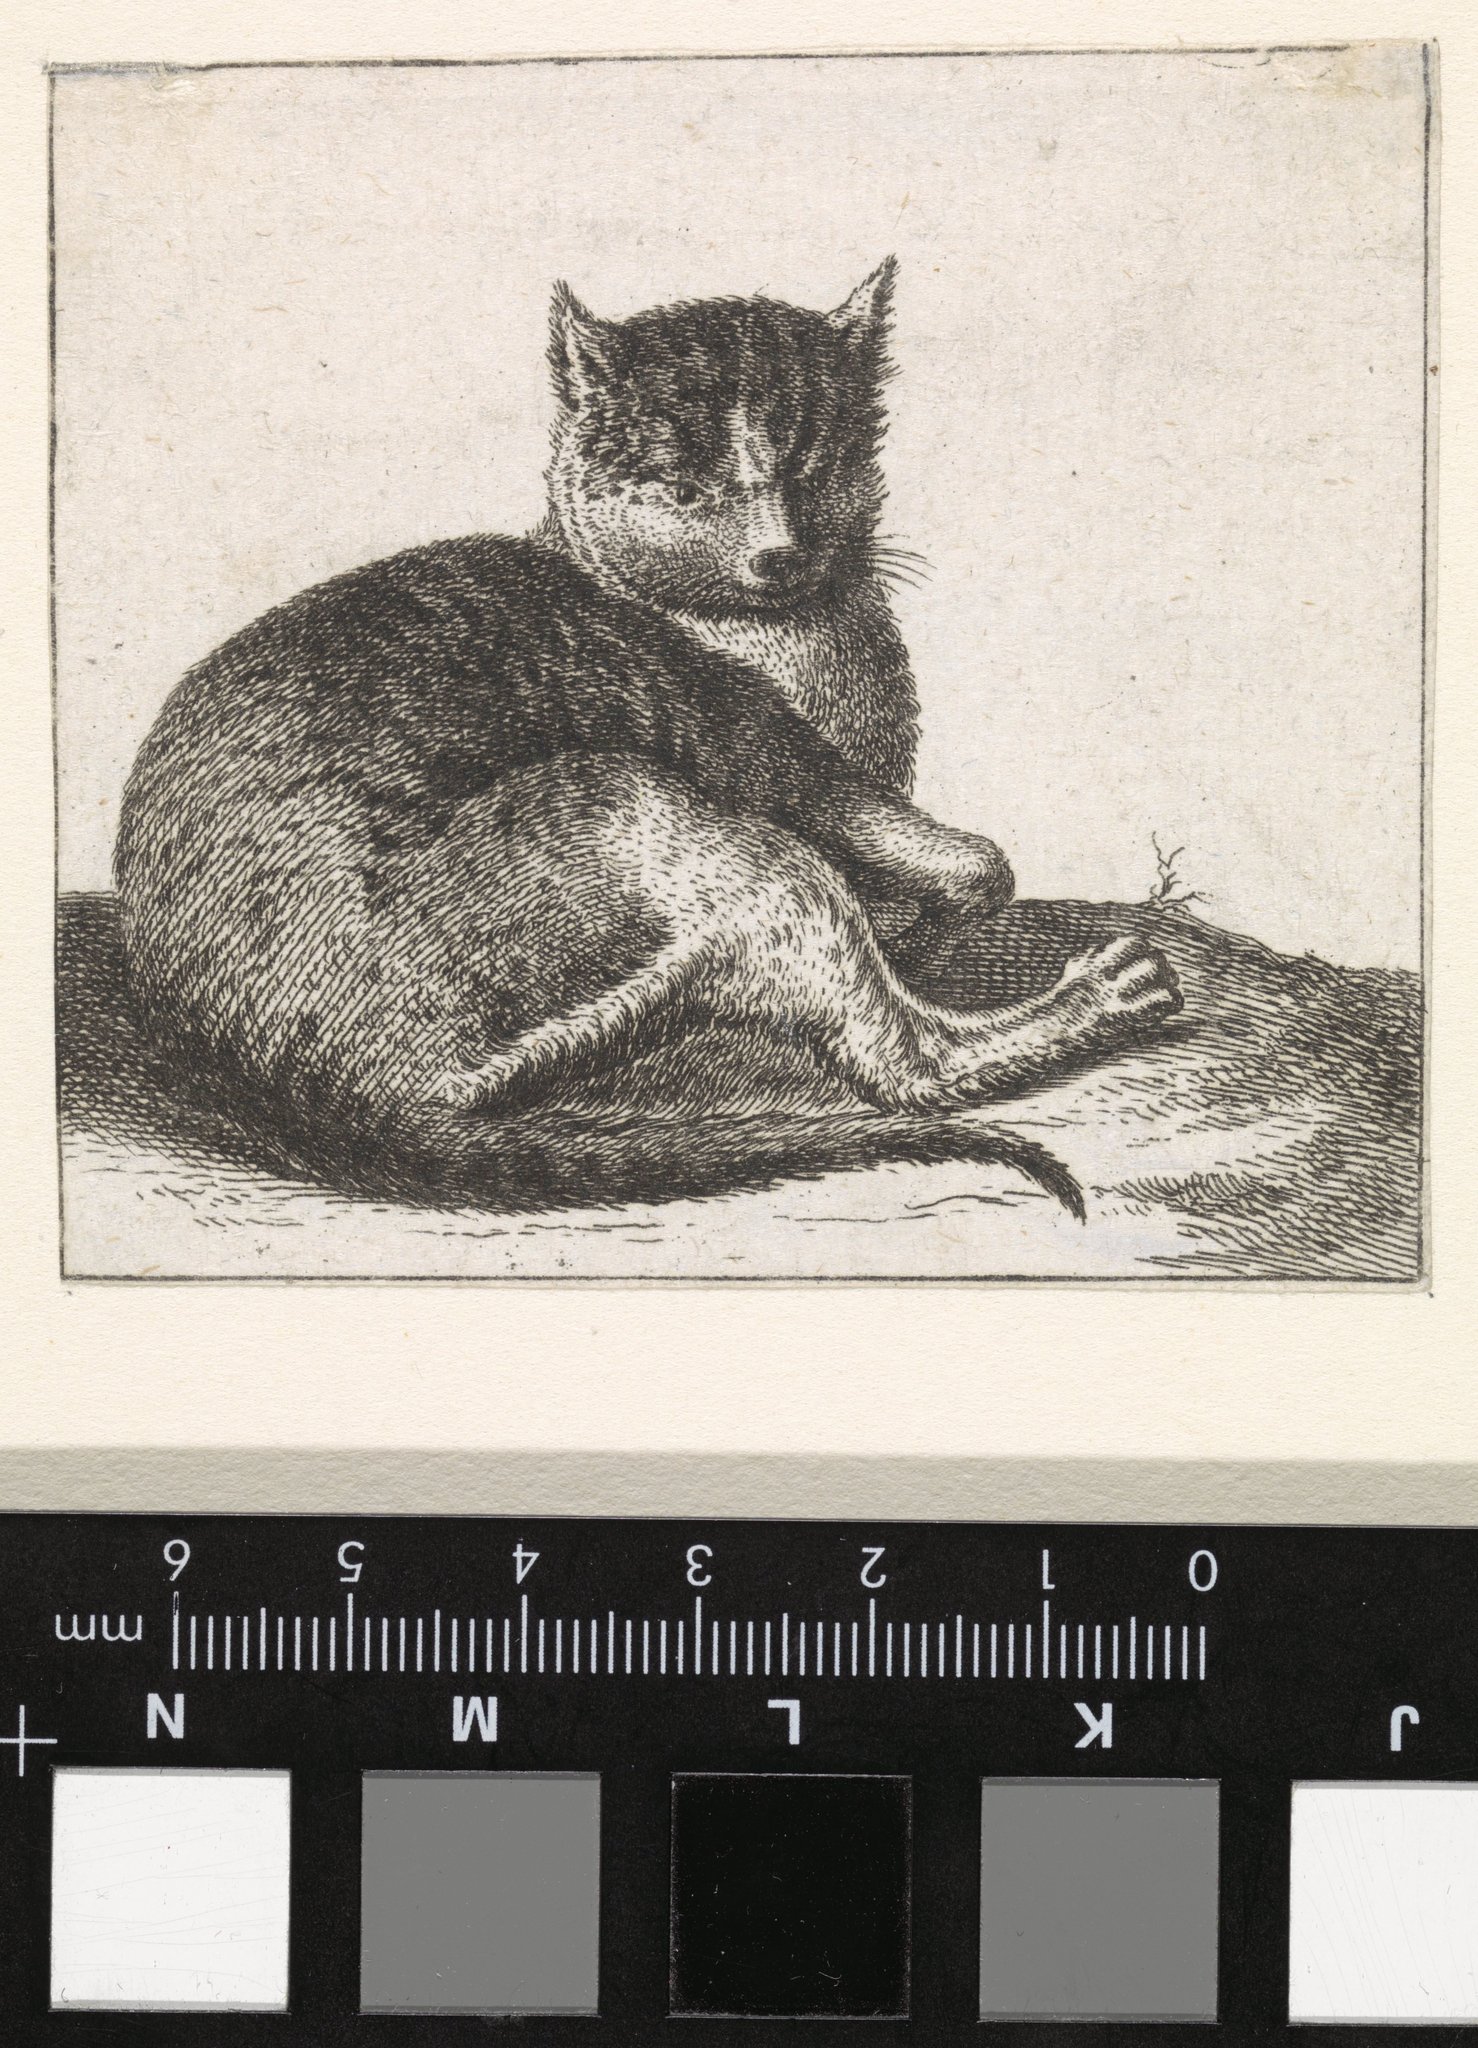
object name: print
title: Liggende poes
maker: Anonymous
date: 1617-1731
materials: paper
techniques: etching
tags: cat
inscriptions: collector's mark, collector's mark: Lugt 2228, collector's mark: Lugt 2760, collector's mark: Lugt 2641b